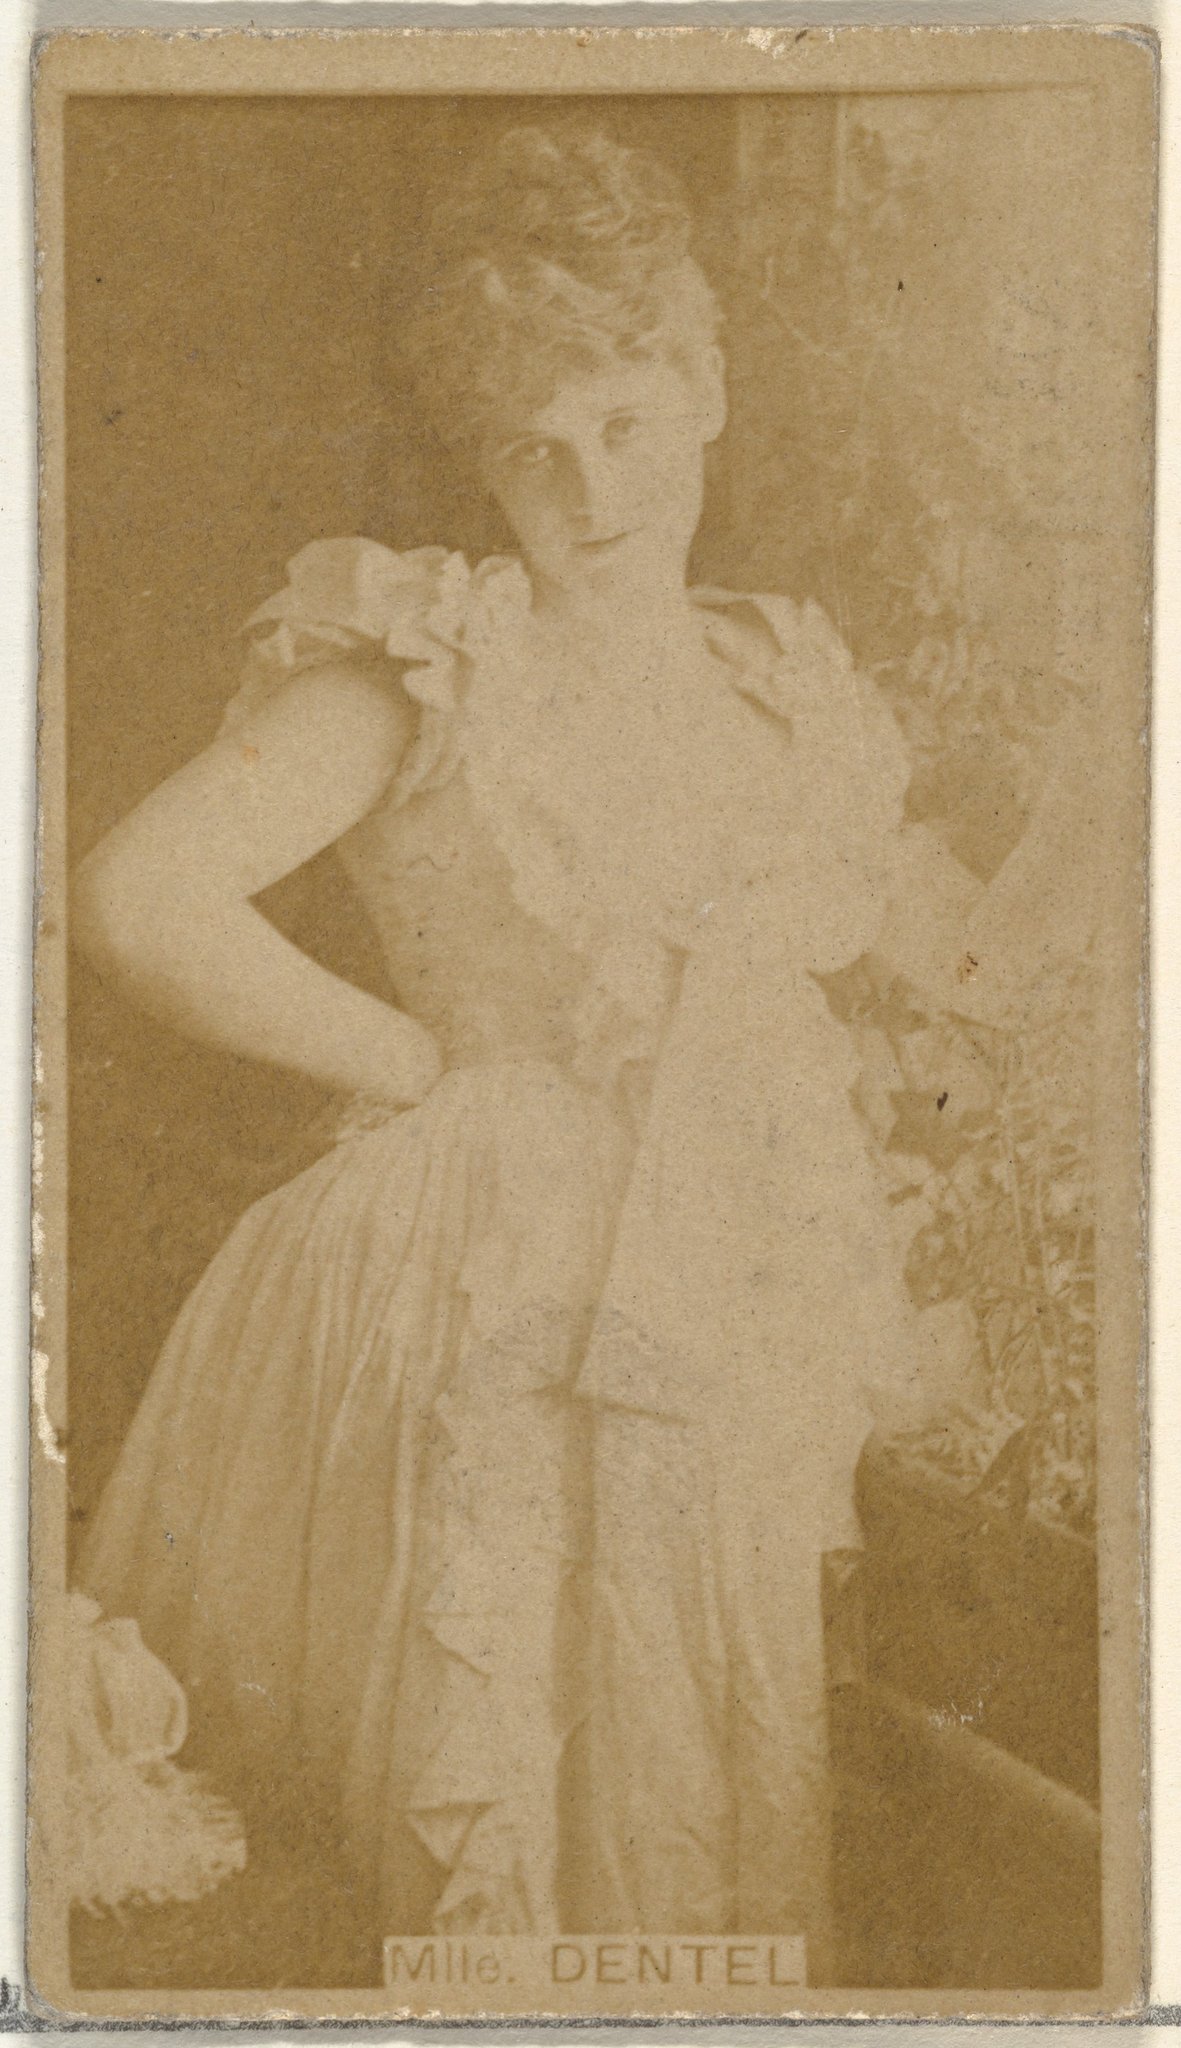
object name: photograph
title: Mlle. Dentel, from the Actors and Actresses series (N145-8) issued by Duke Sons & Co. to promote Duke Cigarettes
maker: w. duke, sons & co.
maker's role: publisher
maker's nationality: american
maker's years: 1870-1920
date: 1891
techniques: albumen silver print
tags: portraits,women,actresses